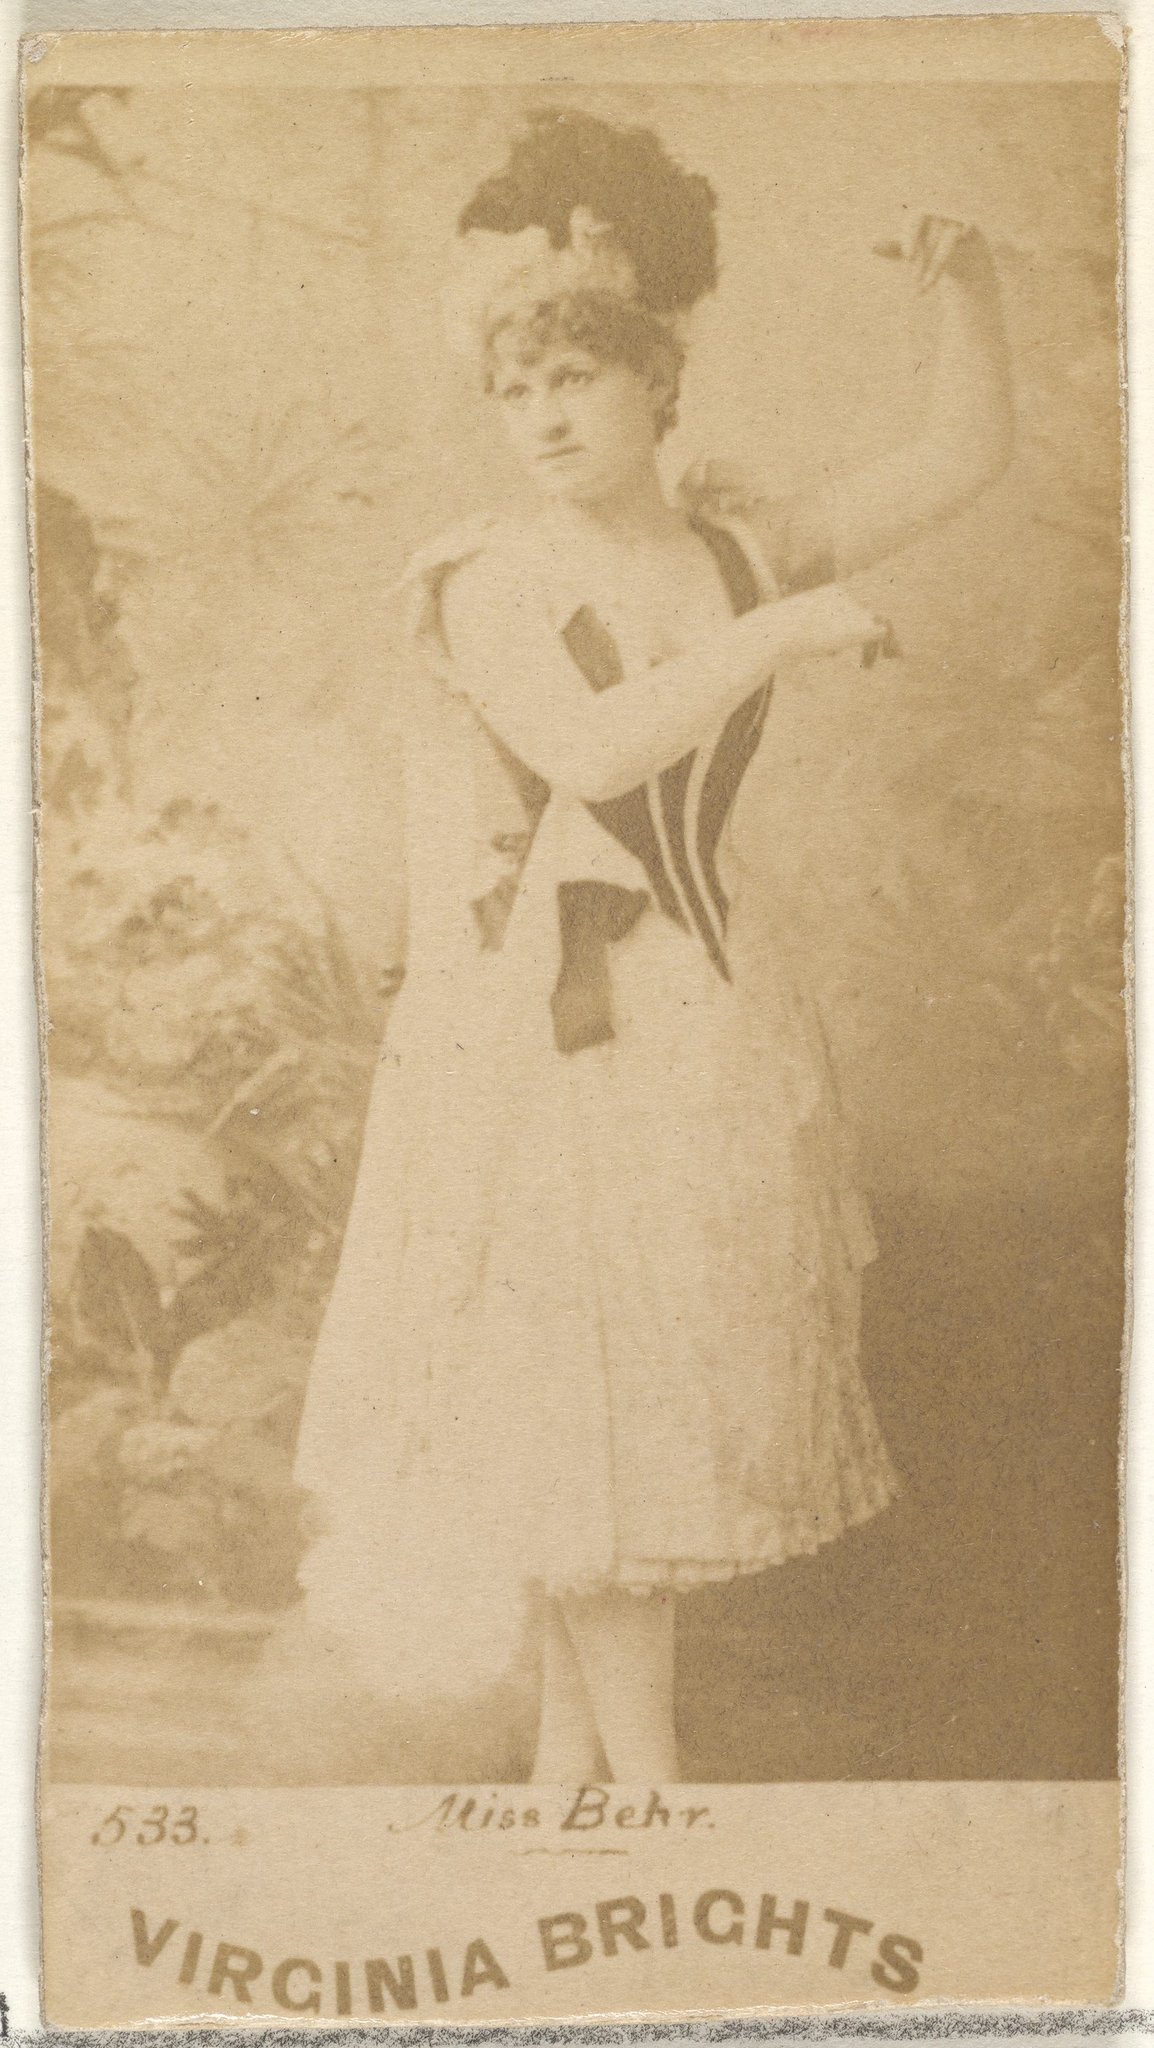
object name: photograph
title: Card 533, Miss Behr, from the Actors and Actresses series (N45, Type 1) for Virginia Brights Cigarettes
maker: allen & ginter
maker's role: publisher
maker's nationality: american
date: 1888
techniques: albumen silver print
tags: portraits,women,actresses